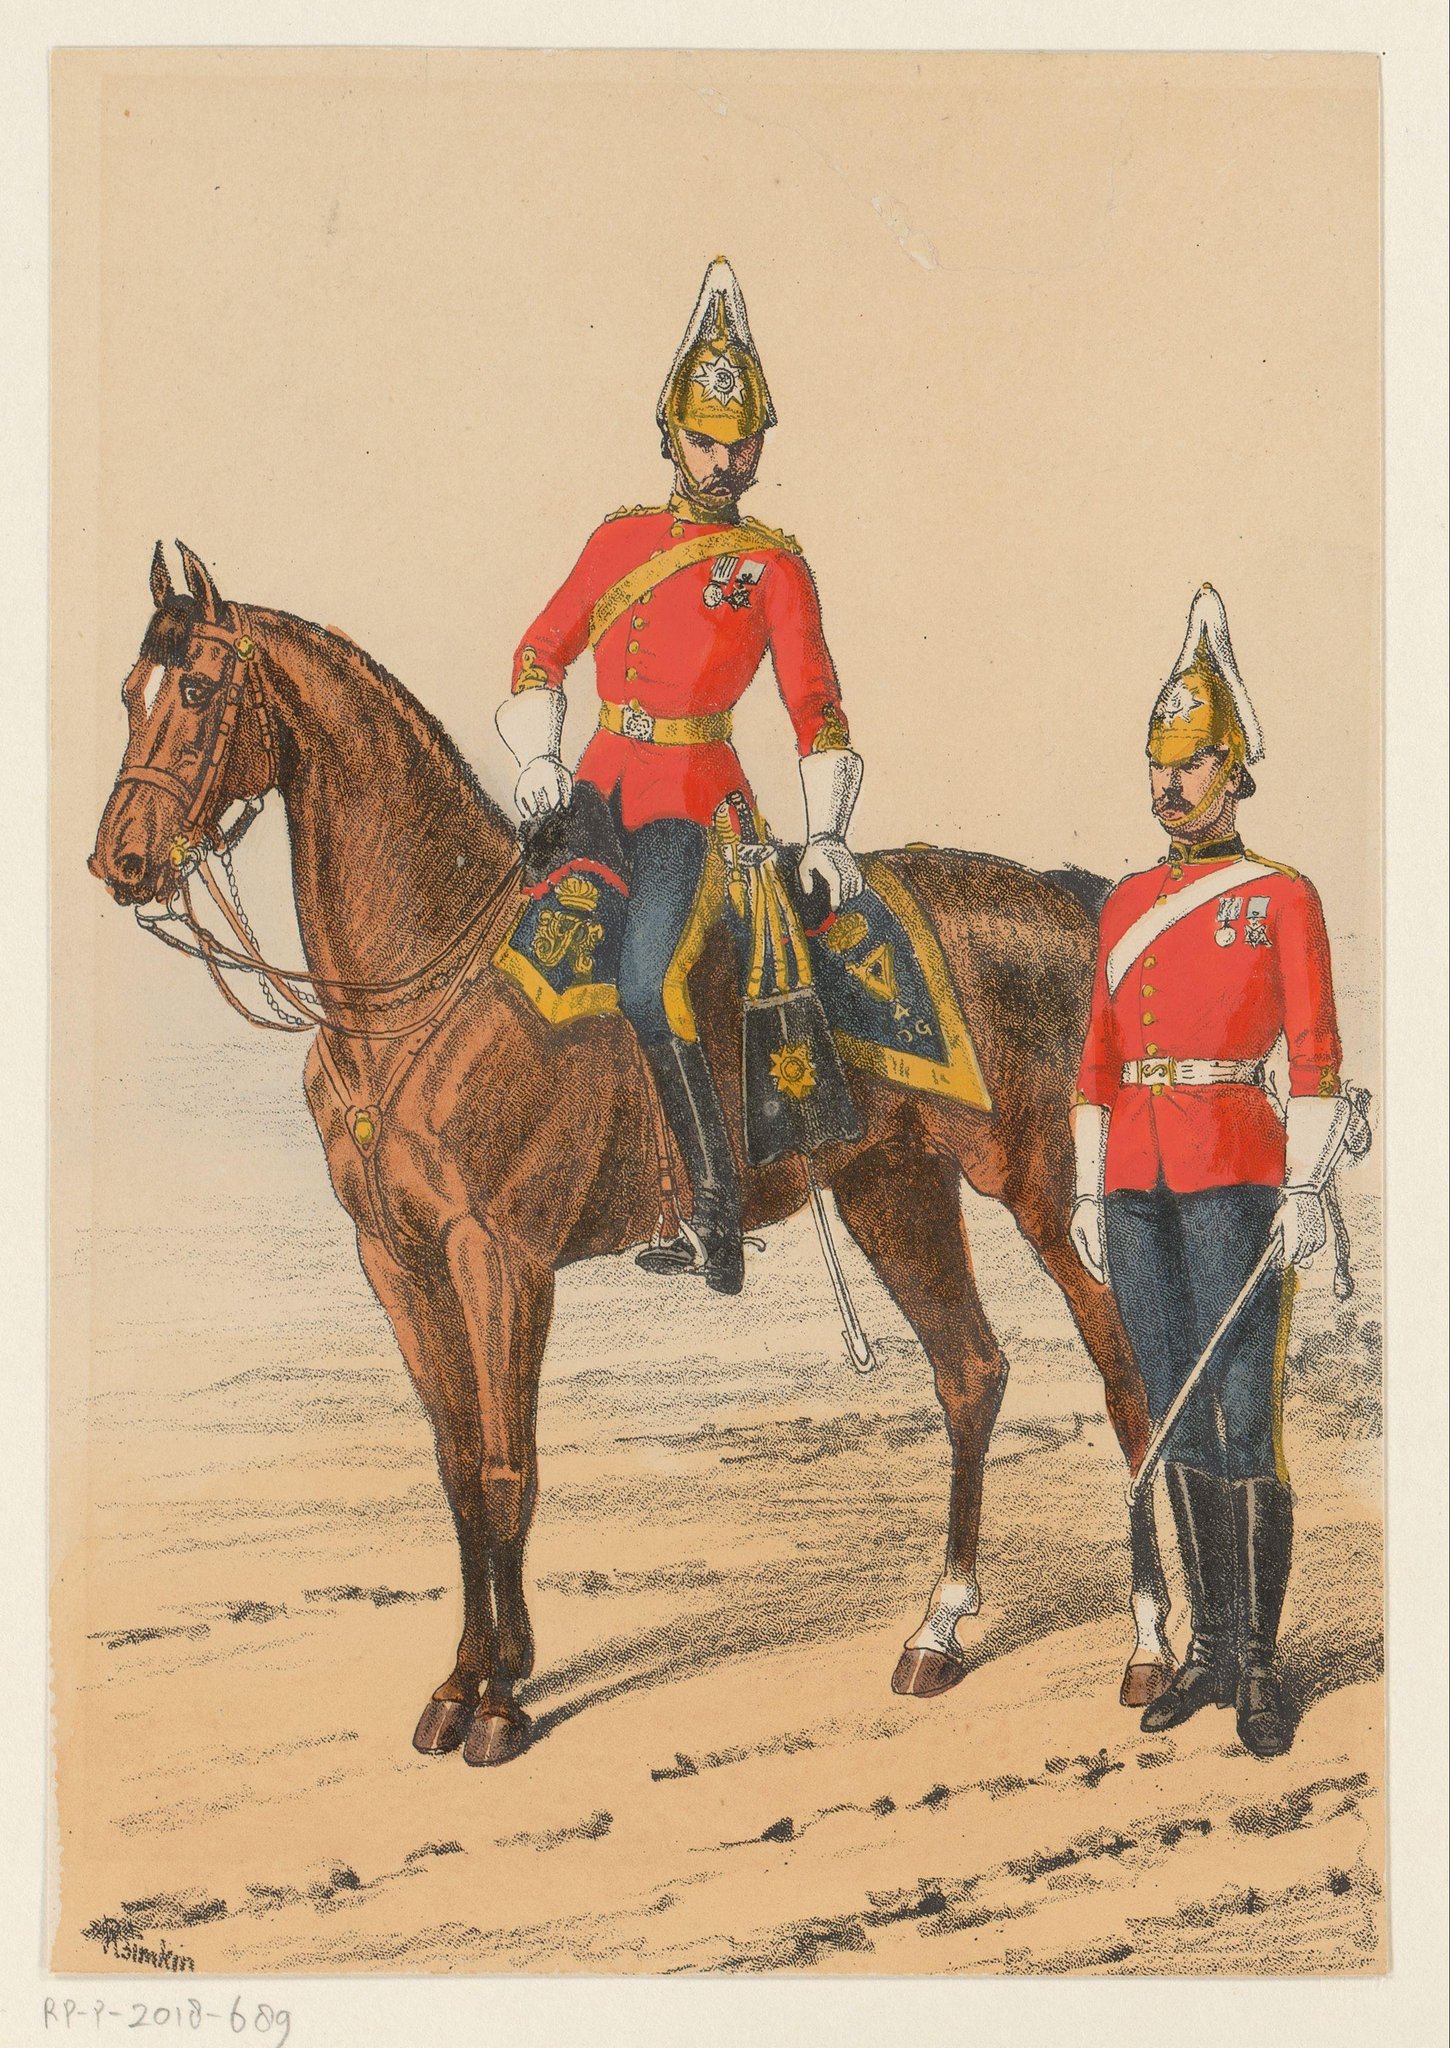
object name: print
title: Twee Britse militairen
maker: richard simkin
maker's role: draughtsman, painter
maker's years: 1840-1926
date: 1875-1925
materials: lacquer, paper, watercolor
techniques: hand coloring, lacquer, lithograph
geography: england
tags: (military) uniforms, great britain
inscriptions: collector's mark: Lugt 2228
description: Twee Britse militairen, één staande, één te paard. Onderdeel van een serie van negen voorstellingen van Britse militaire uniformen.